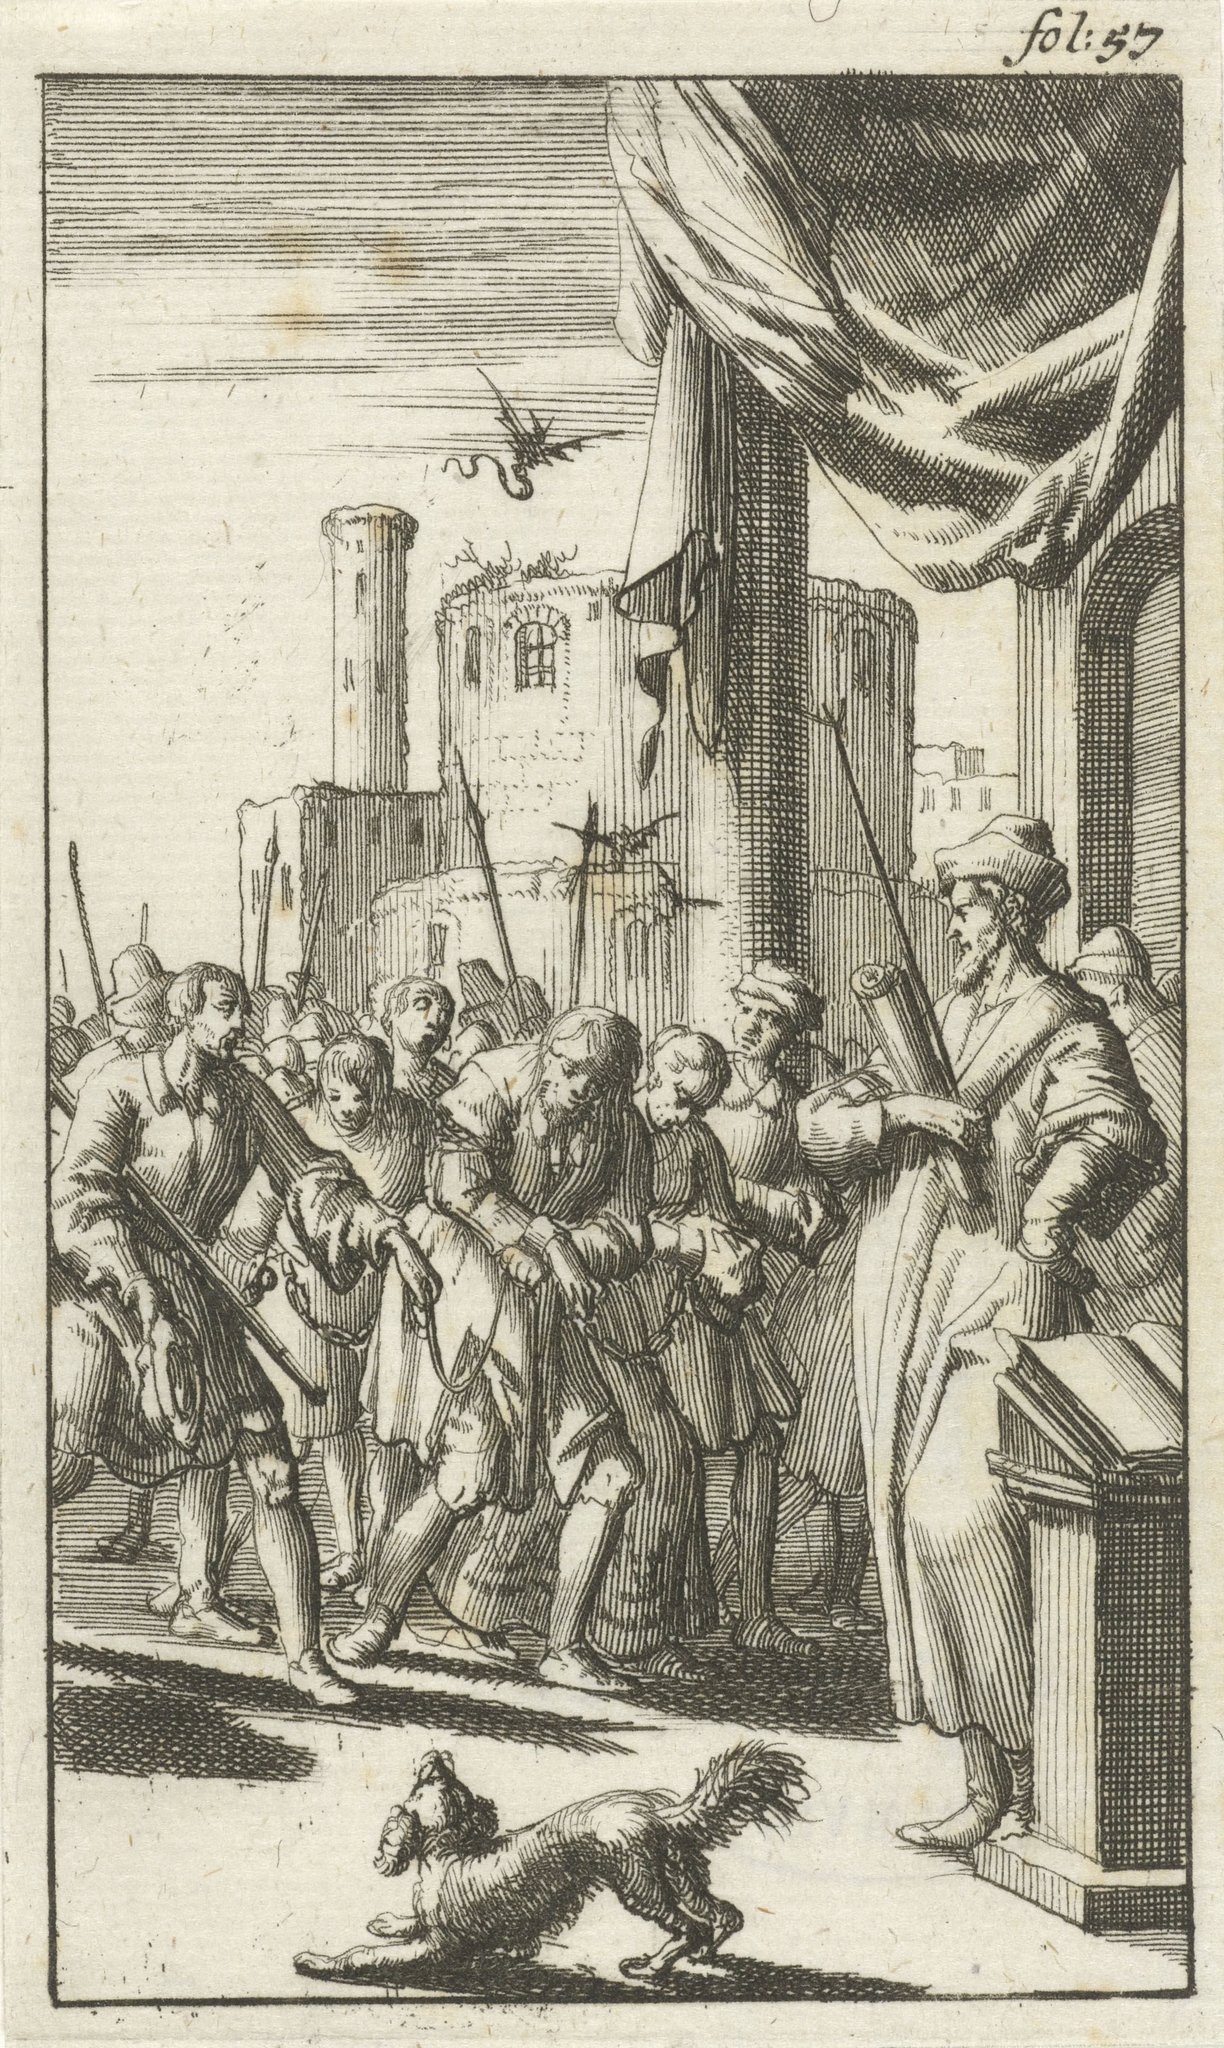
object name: book illustration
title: Gevangenen worden geboeid voor de rechter geleid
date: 1687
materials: paper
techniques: etching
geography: amsterdam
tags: prisoner; in fetters, magistracy, judges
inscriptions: collector's mark: Lugt 2228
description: Illustratie uit: Bernard, Richard. Het menschen-eyland, ofte Rechts-pligtige procedure tegens de sonde, in't raad-huys van 'smenschen-herte. Amsterdam: Abraham Boekholt, 1686.